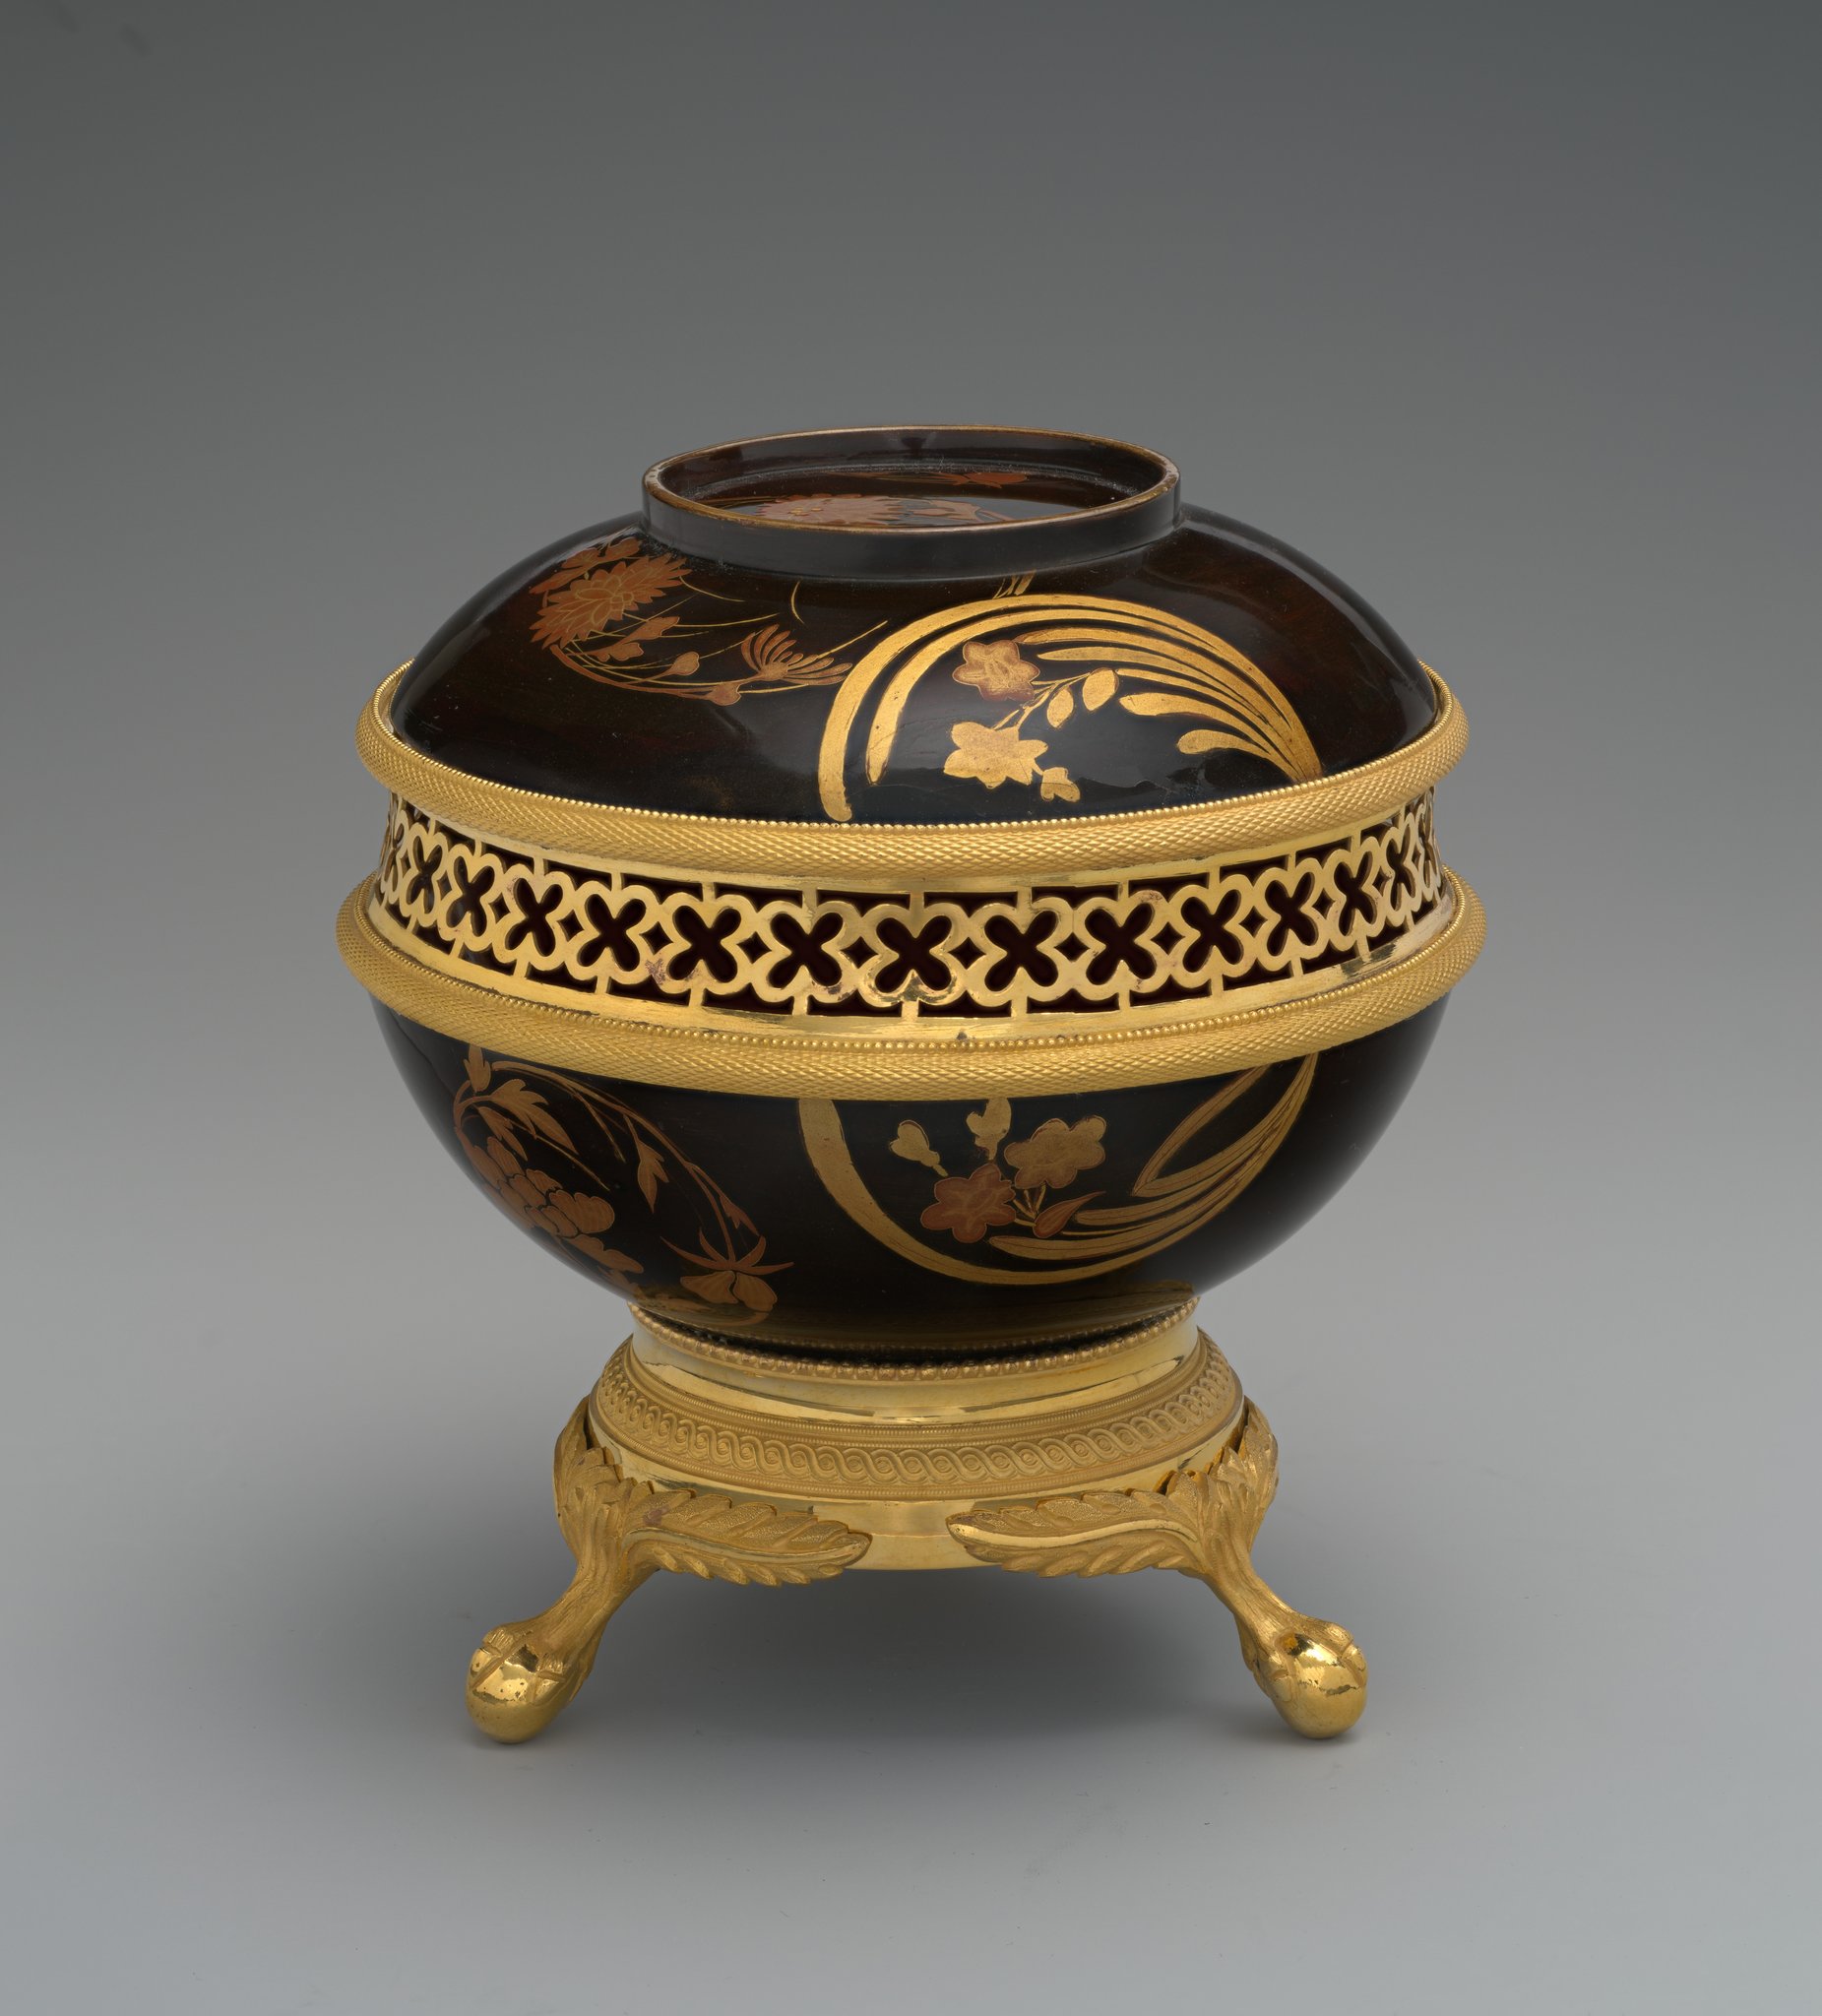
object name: potpourri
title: Potpourri vessel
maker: benjamin vulliamy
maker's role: maker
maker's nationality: british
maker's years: 1747-1811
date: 1800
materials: bronze, wood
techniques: gilding, lacquer